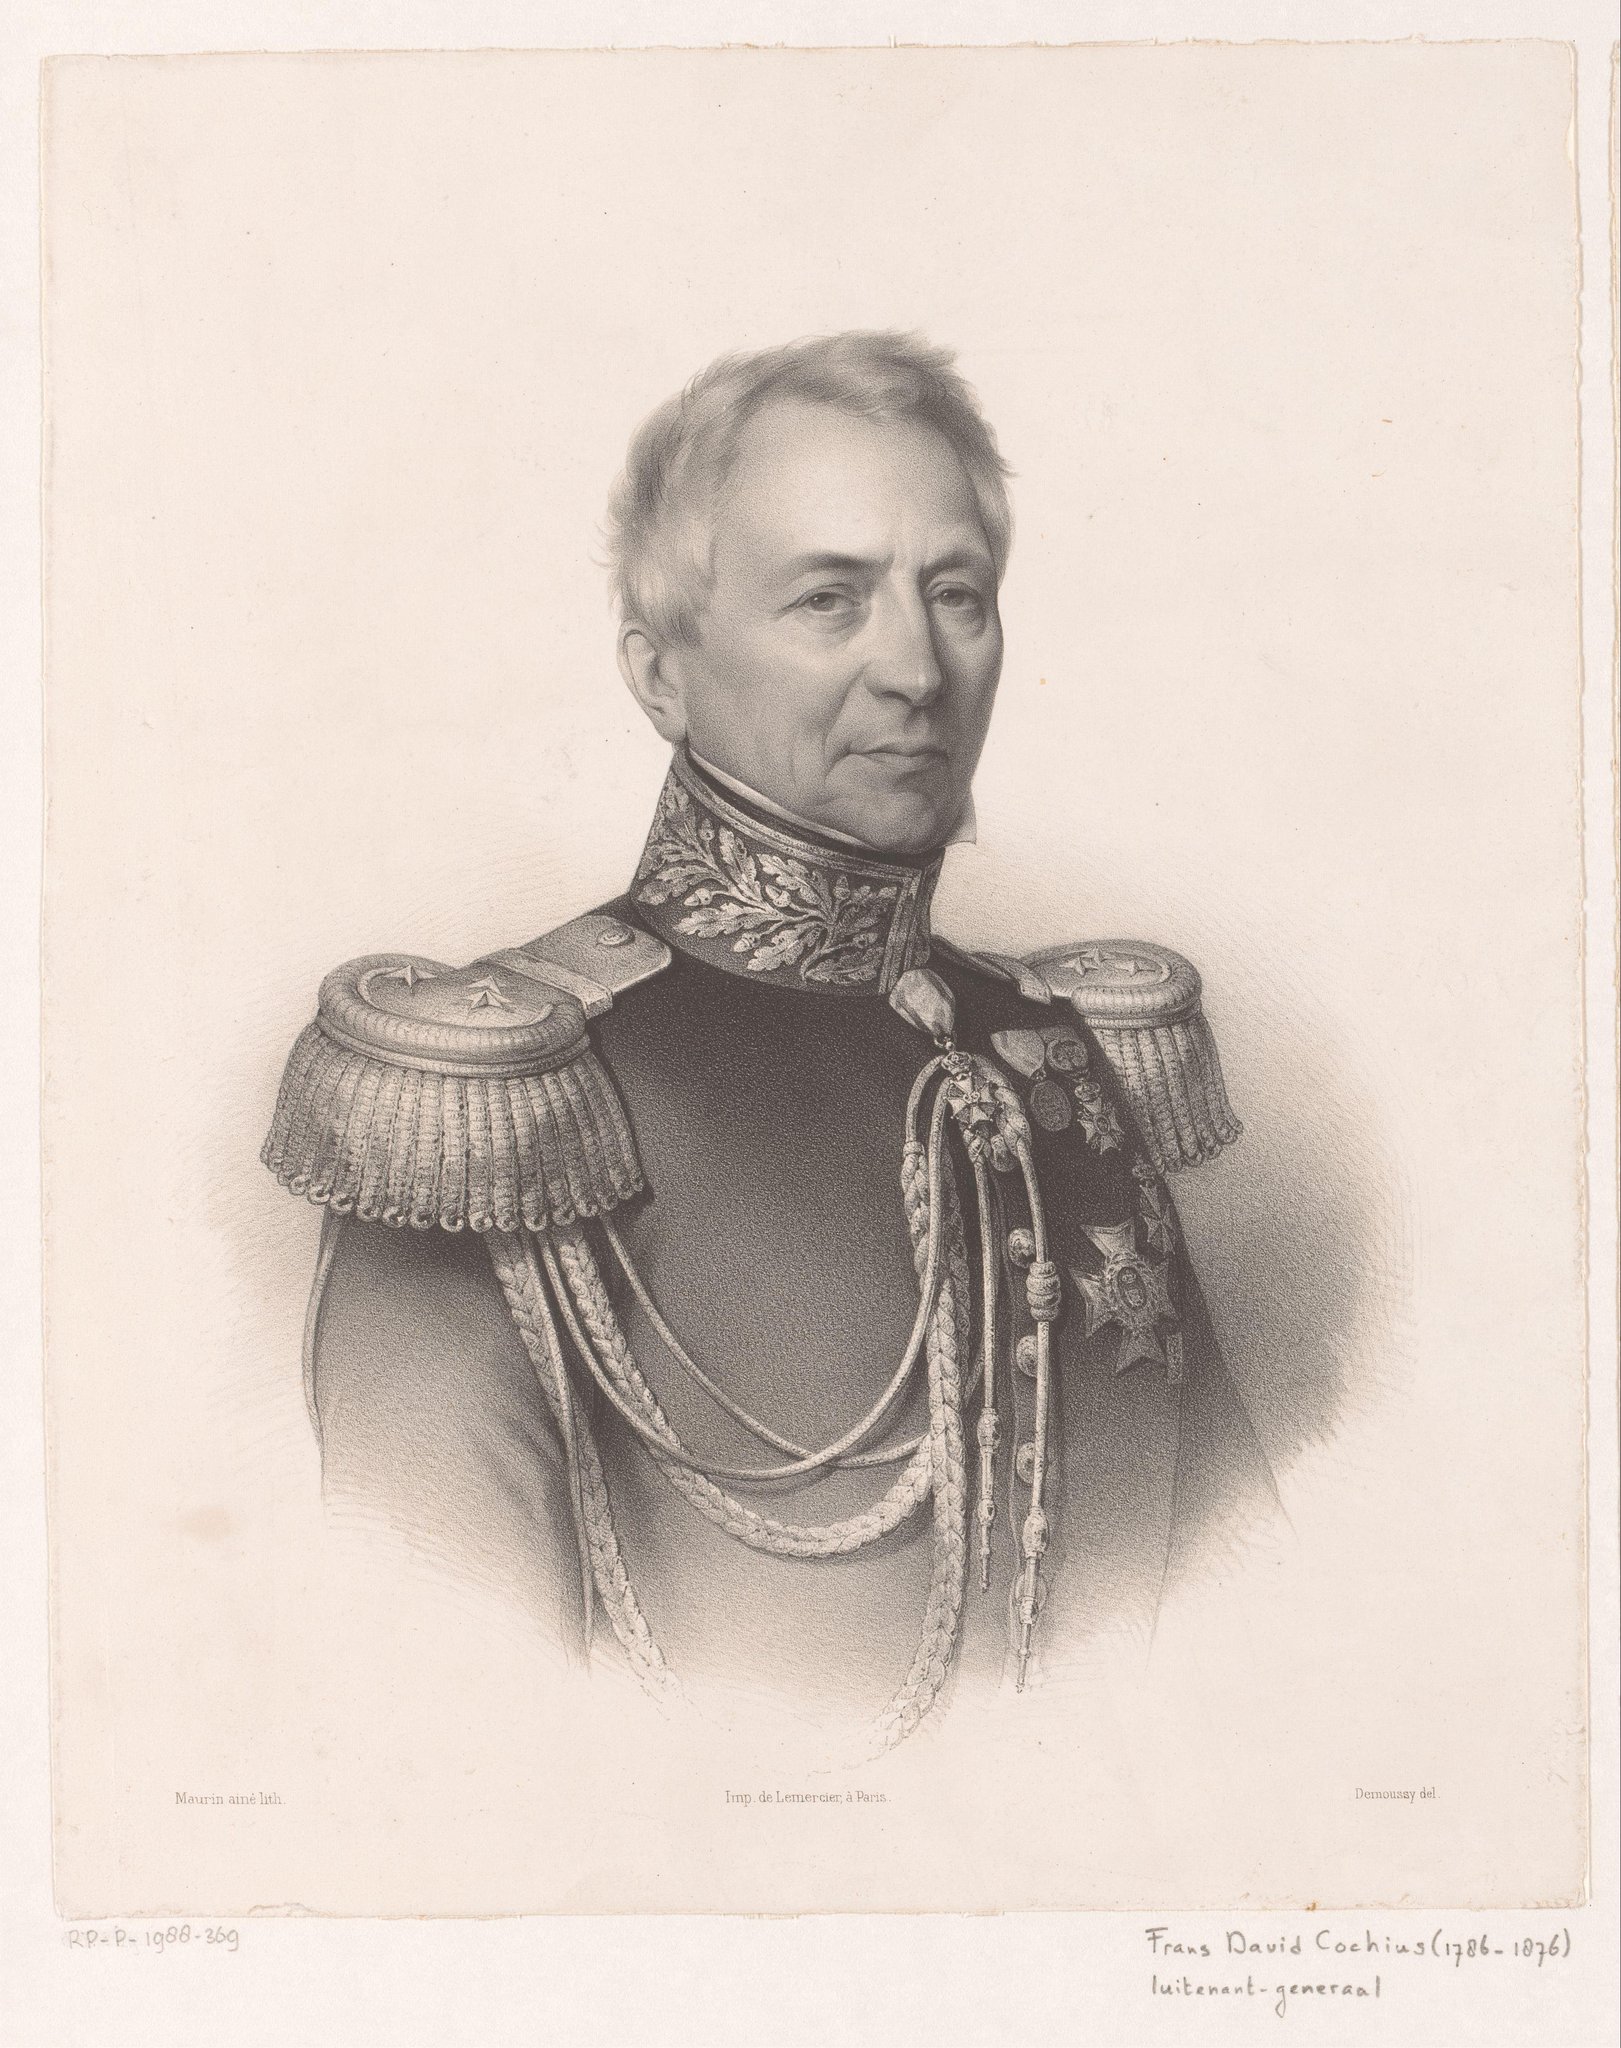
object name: print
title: Portret van Frans David Cochius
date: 1848-1887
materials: paper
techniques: lithograph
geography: paris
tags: historical persons, officer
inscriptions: collector's mark: Lugt 2228